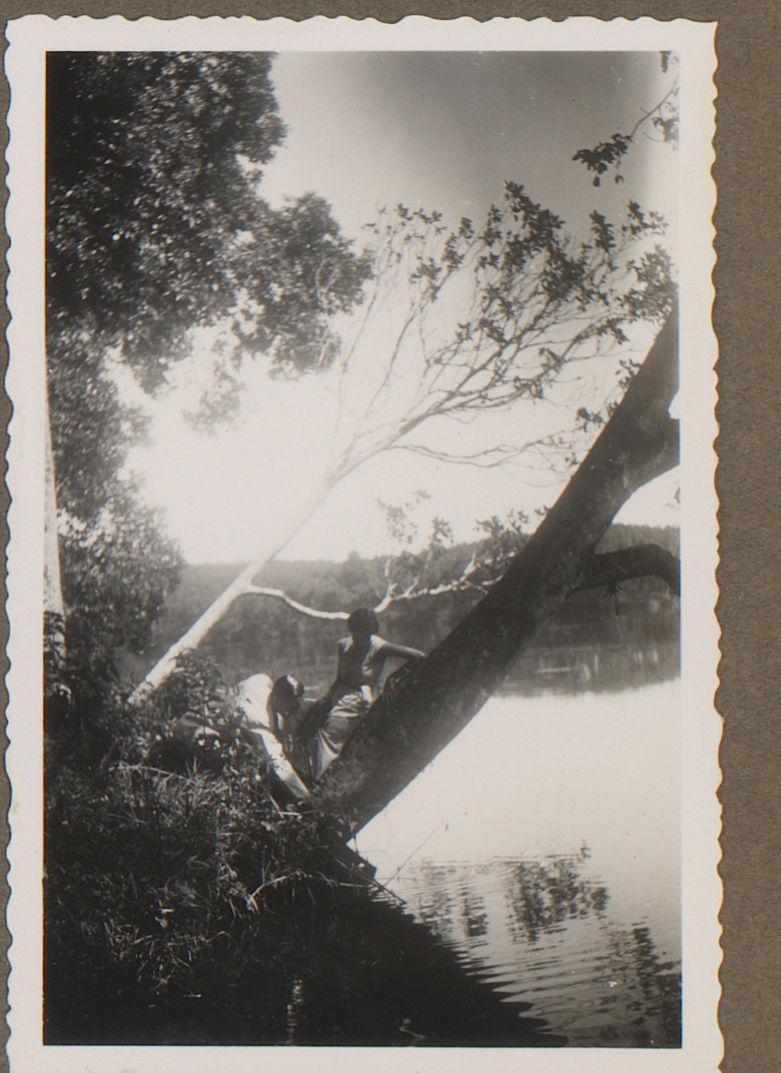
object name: photograph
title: Dootje van Zijll de Jong en een man bij een meer, nabij Bandoeng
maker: Anonymous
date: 1933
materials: paper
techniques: gelatin silver print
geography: west java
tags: amsterdam, lake